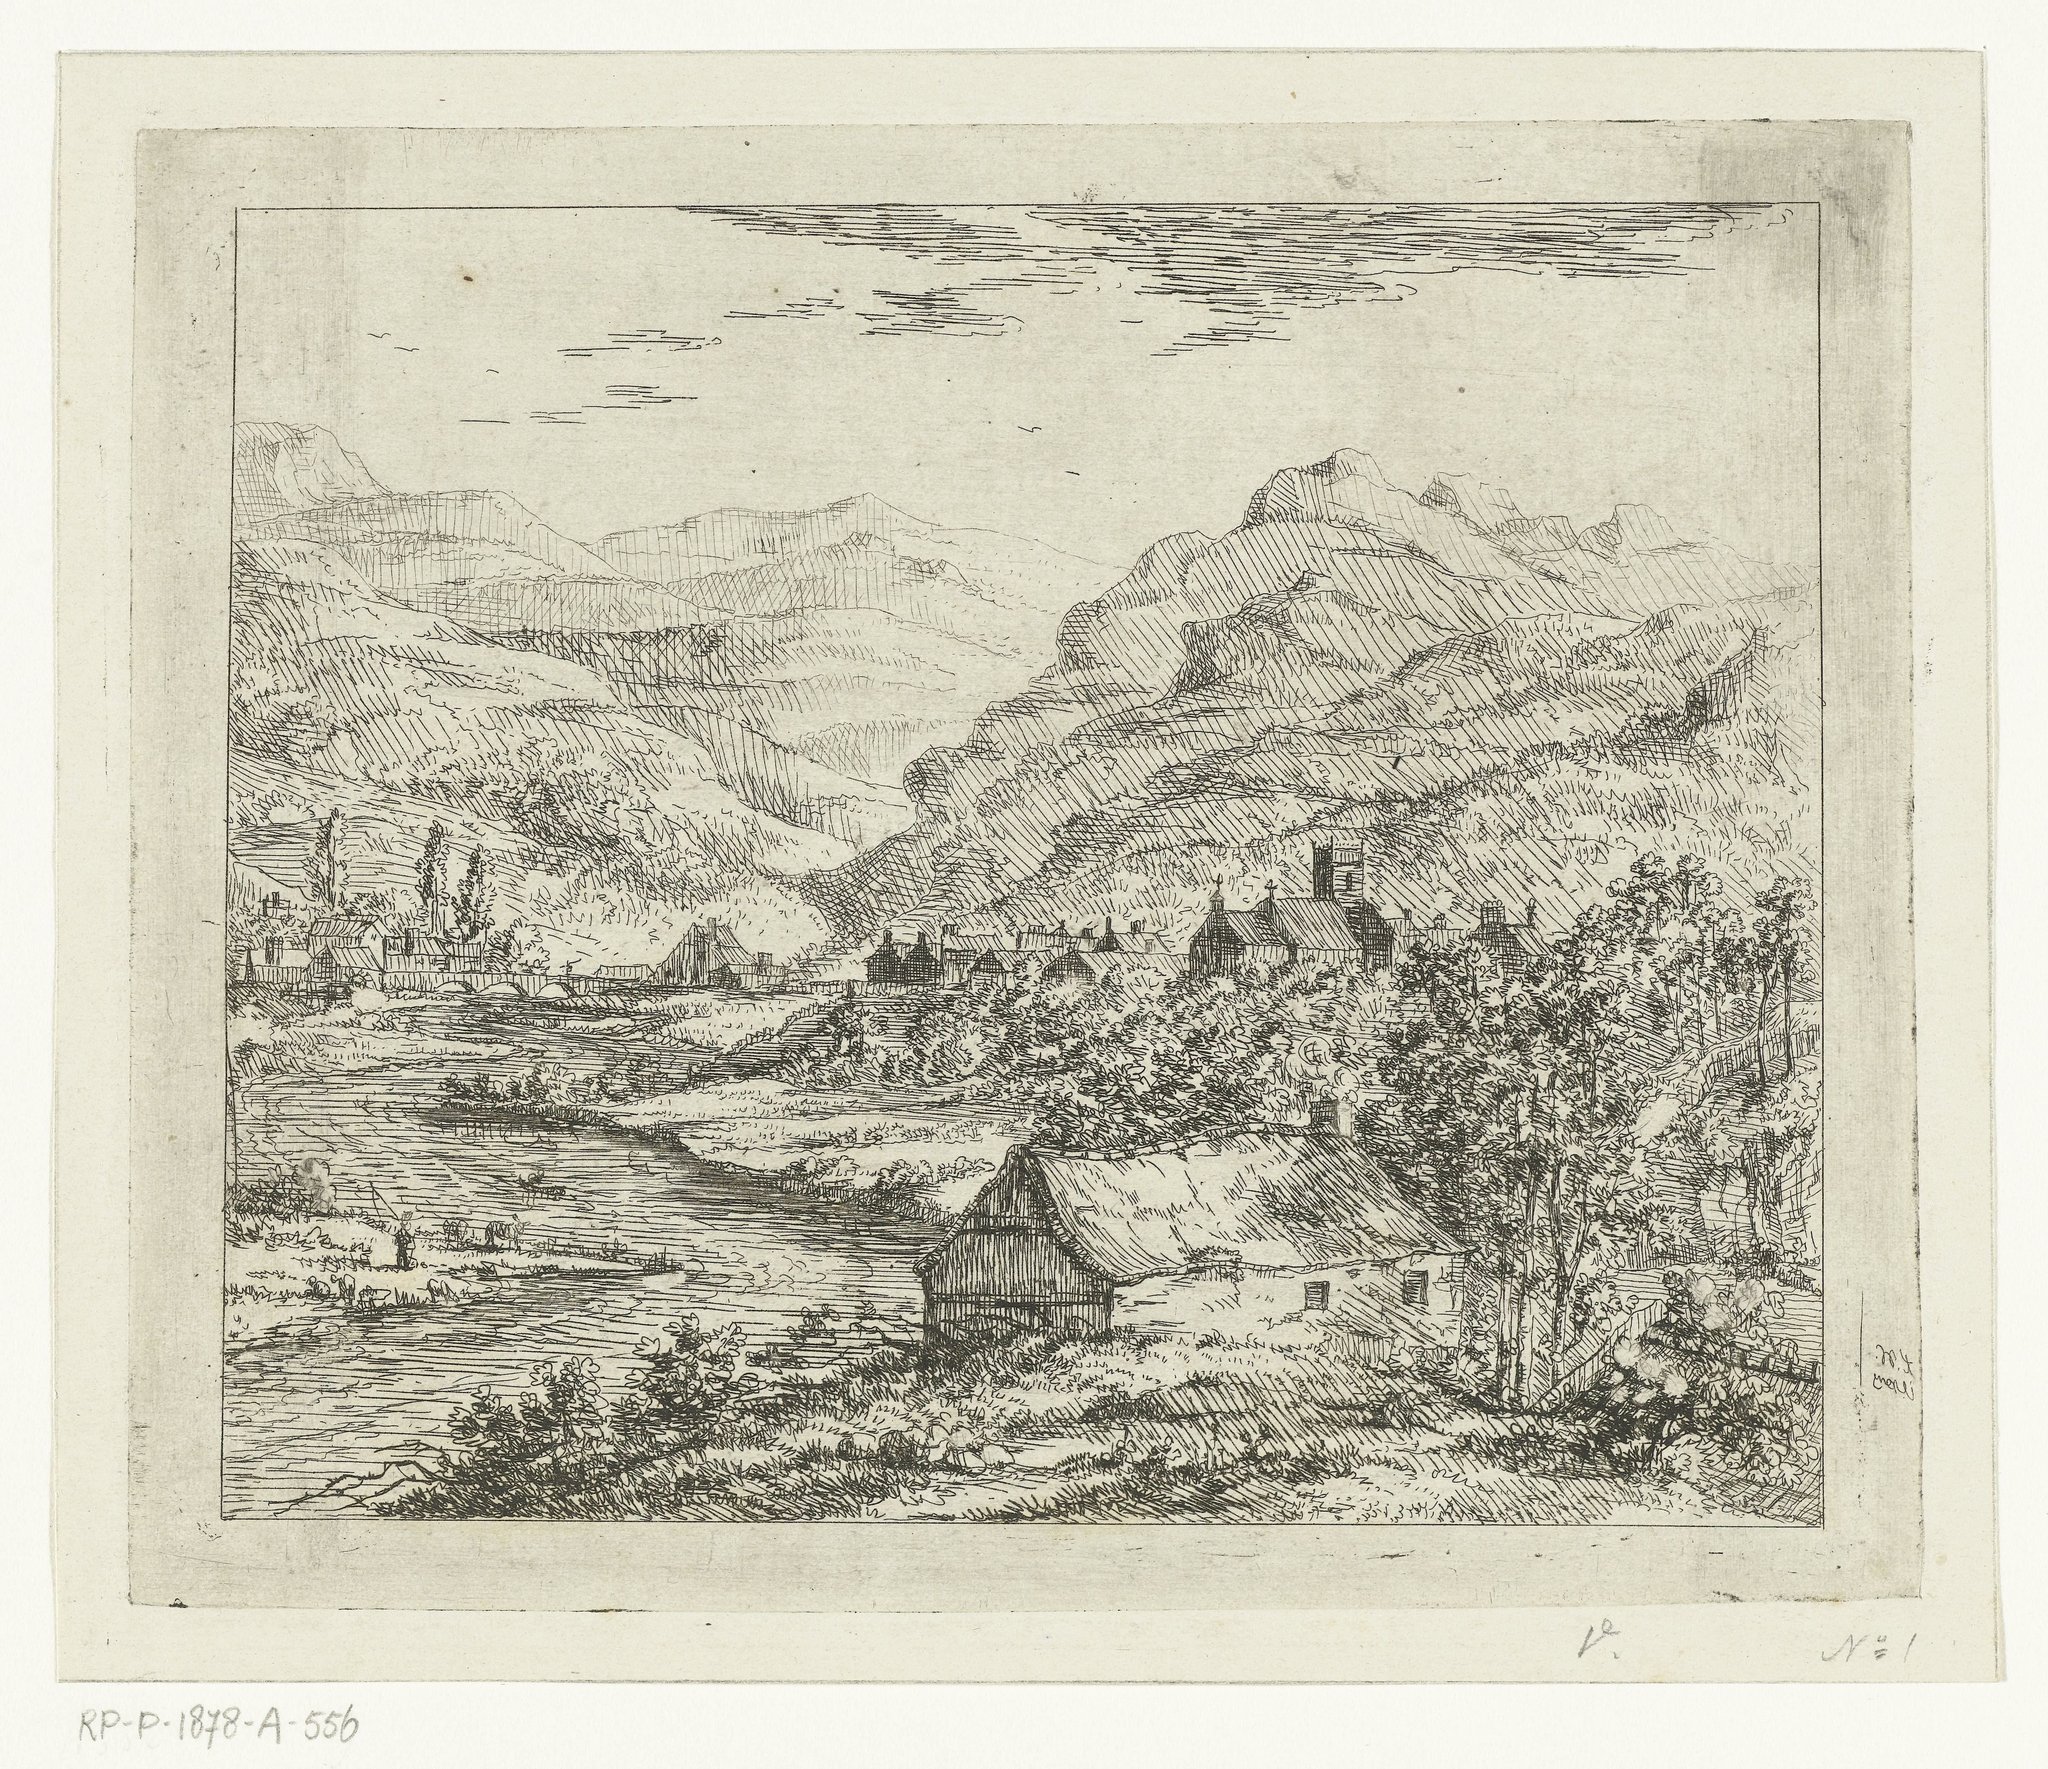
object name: print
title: Gezicht in de Hooglanden te Schotland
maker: dirk vis blokhuyzen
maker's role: print maker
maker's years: 1799-1869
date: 1809-1869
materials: paper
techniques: etching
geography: rotterdam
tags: low hill country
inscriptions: collector's mark: Lugt 2228